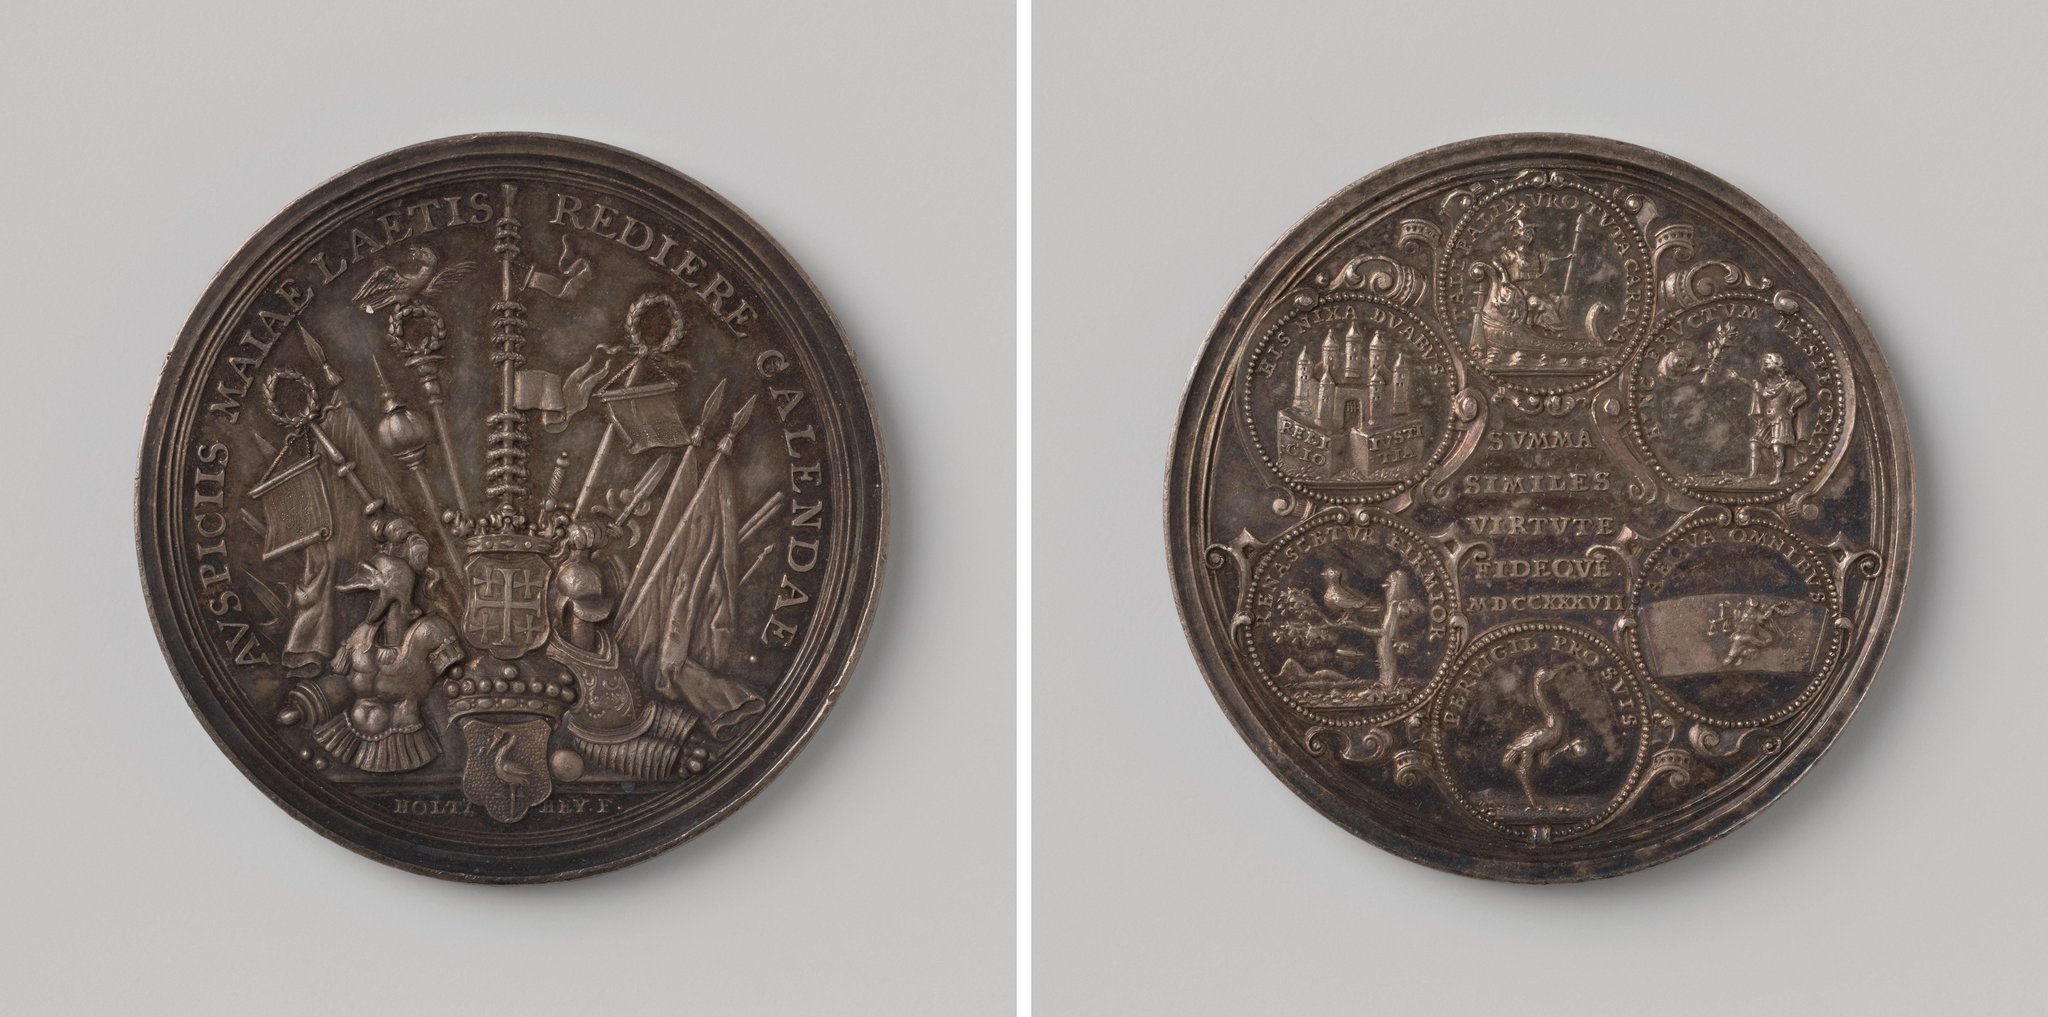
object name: history medal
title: Planting van de meiboom te 's-Gravenhage door de schutterij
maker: martinus holtzhey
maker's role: medailleur, muntmaker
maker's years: 1697-1764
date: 1737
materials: silver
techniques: striking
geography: amsterdam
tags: the hague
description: Zilveren penning. Voorzijde: met lauwerkransen versierde meiboom, waaronder een gekroond wapenschild staande tussen twee harnassen, vaandels en oorlogstuig, daaronder gekroond wapenschild; met een lint zijn vier wapenschilden aan de top van de meiboom gebonden. Keerzijde: opschrift binnen ring van zes wapenschilden, die aan meiboom gehangen werden.